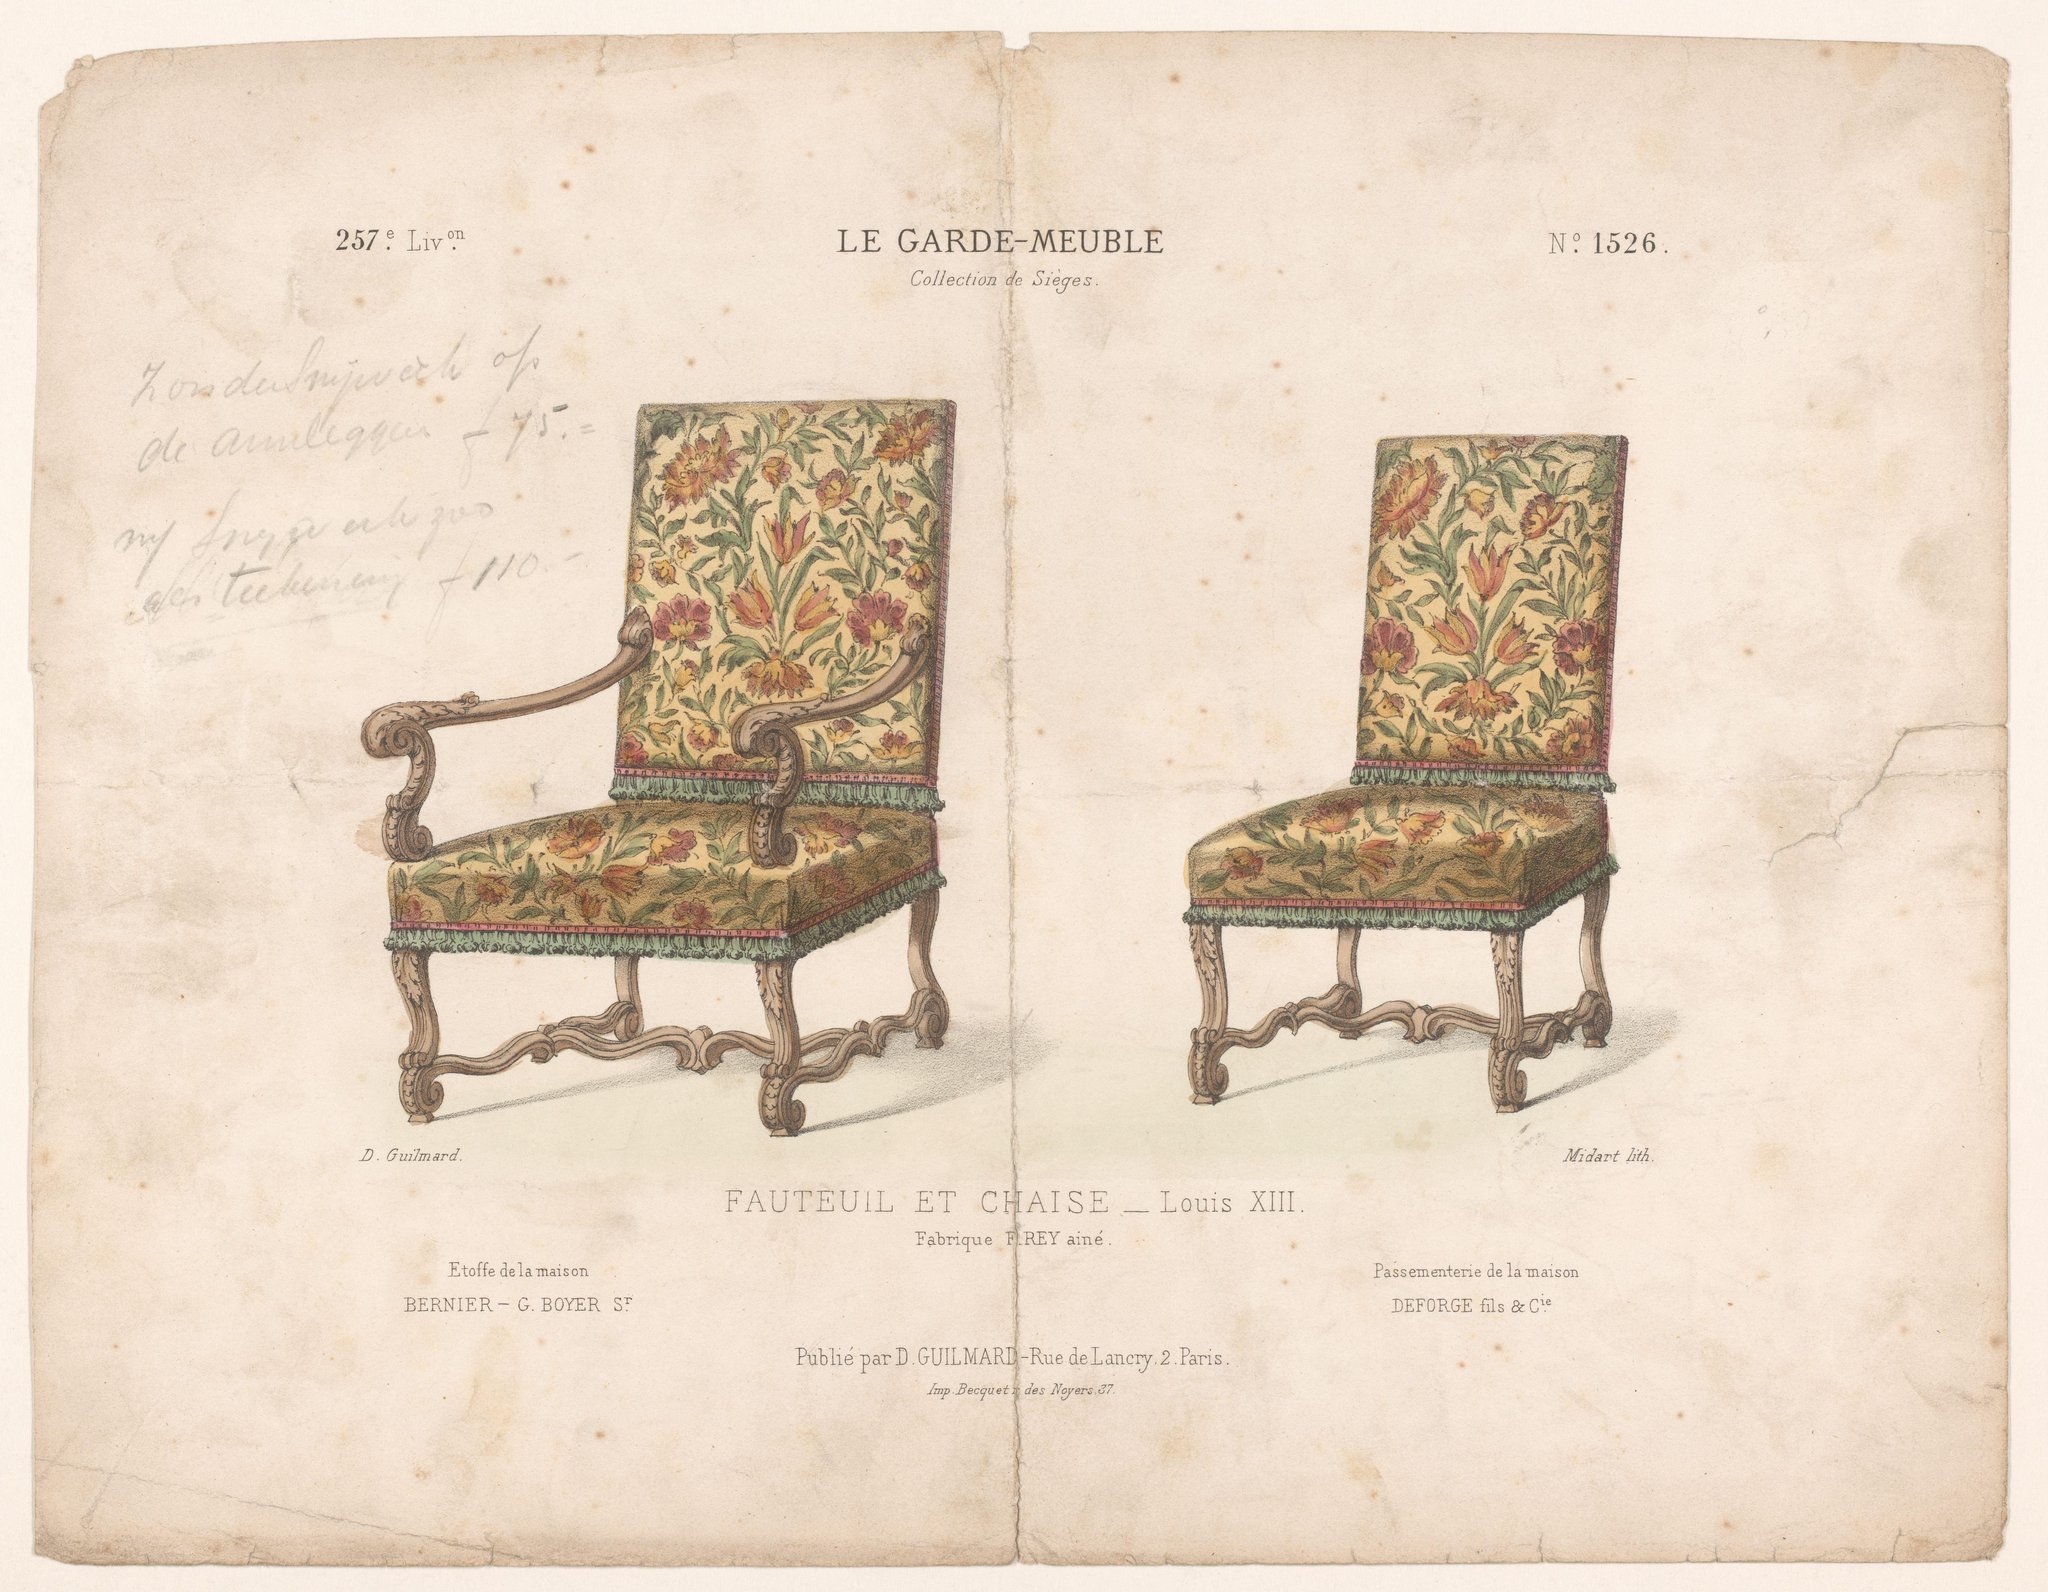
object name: print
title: Le garde-meuble / Collection de Sièges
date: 1839-1885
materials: paper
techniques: hand coloring, lithograph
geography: paris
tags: seating furniture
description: Ieder Livraison in de serie Le Garde-Meuble bevat negen platen: drie 'sièges' (zitmeubels), drie 'meubles' (diverse meubels zoals tafels en kasten) en drie 'tentures' (gordijnen en draperieën).